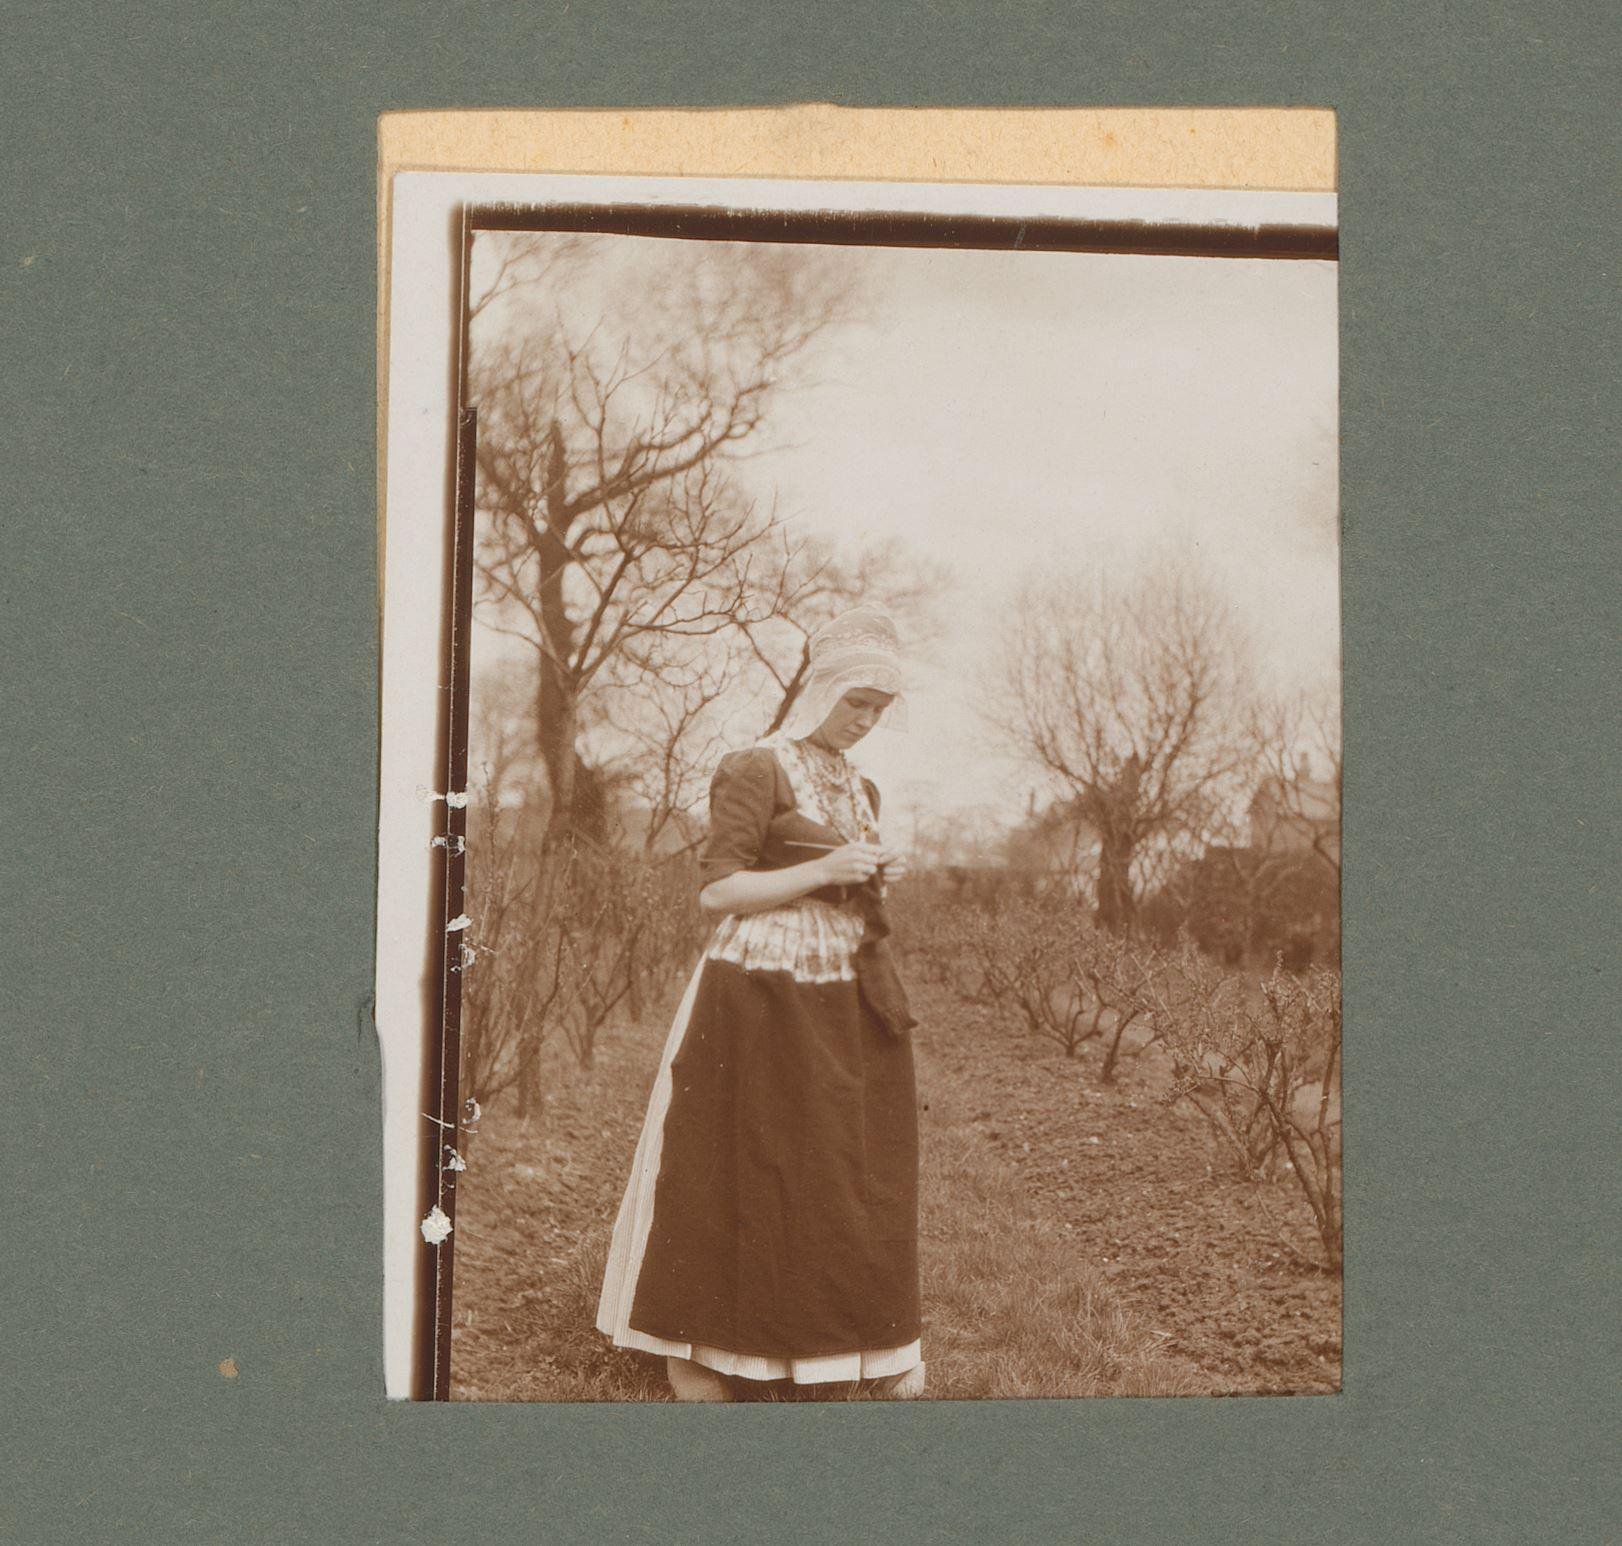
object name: photograph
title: Vrouw in klederdracht met breiwerk, staande tussen kale bomen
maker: george hidderley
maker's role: fotograaf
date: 1920-1940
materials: photographic support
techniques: collodion silver print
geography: netherlands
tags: trees, historical persons - bb - woman, folk costume, regional costume, knitting